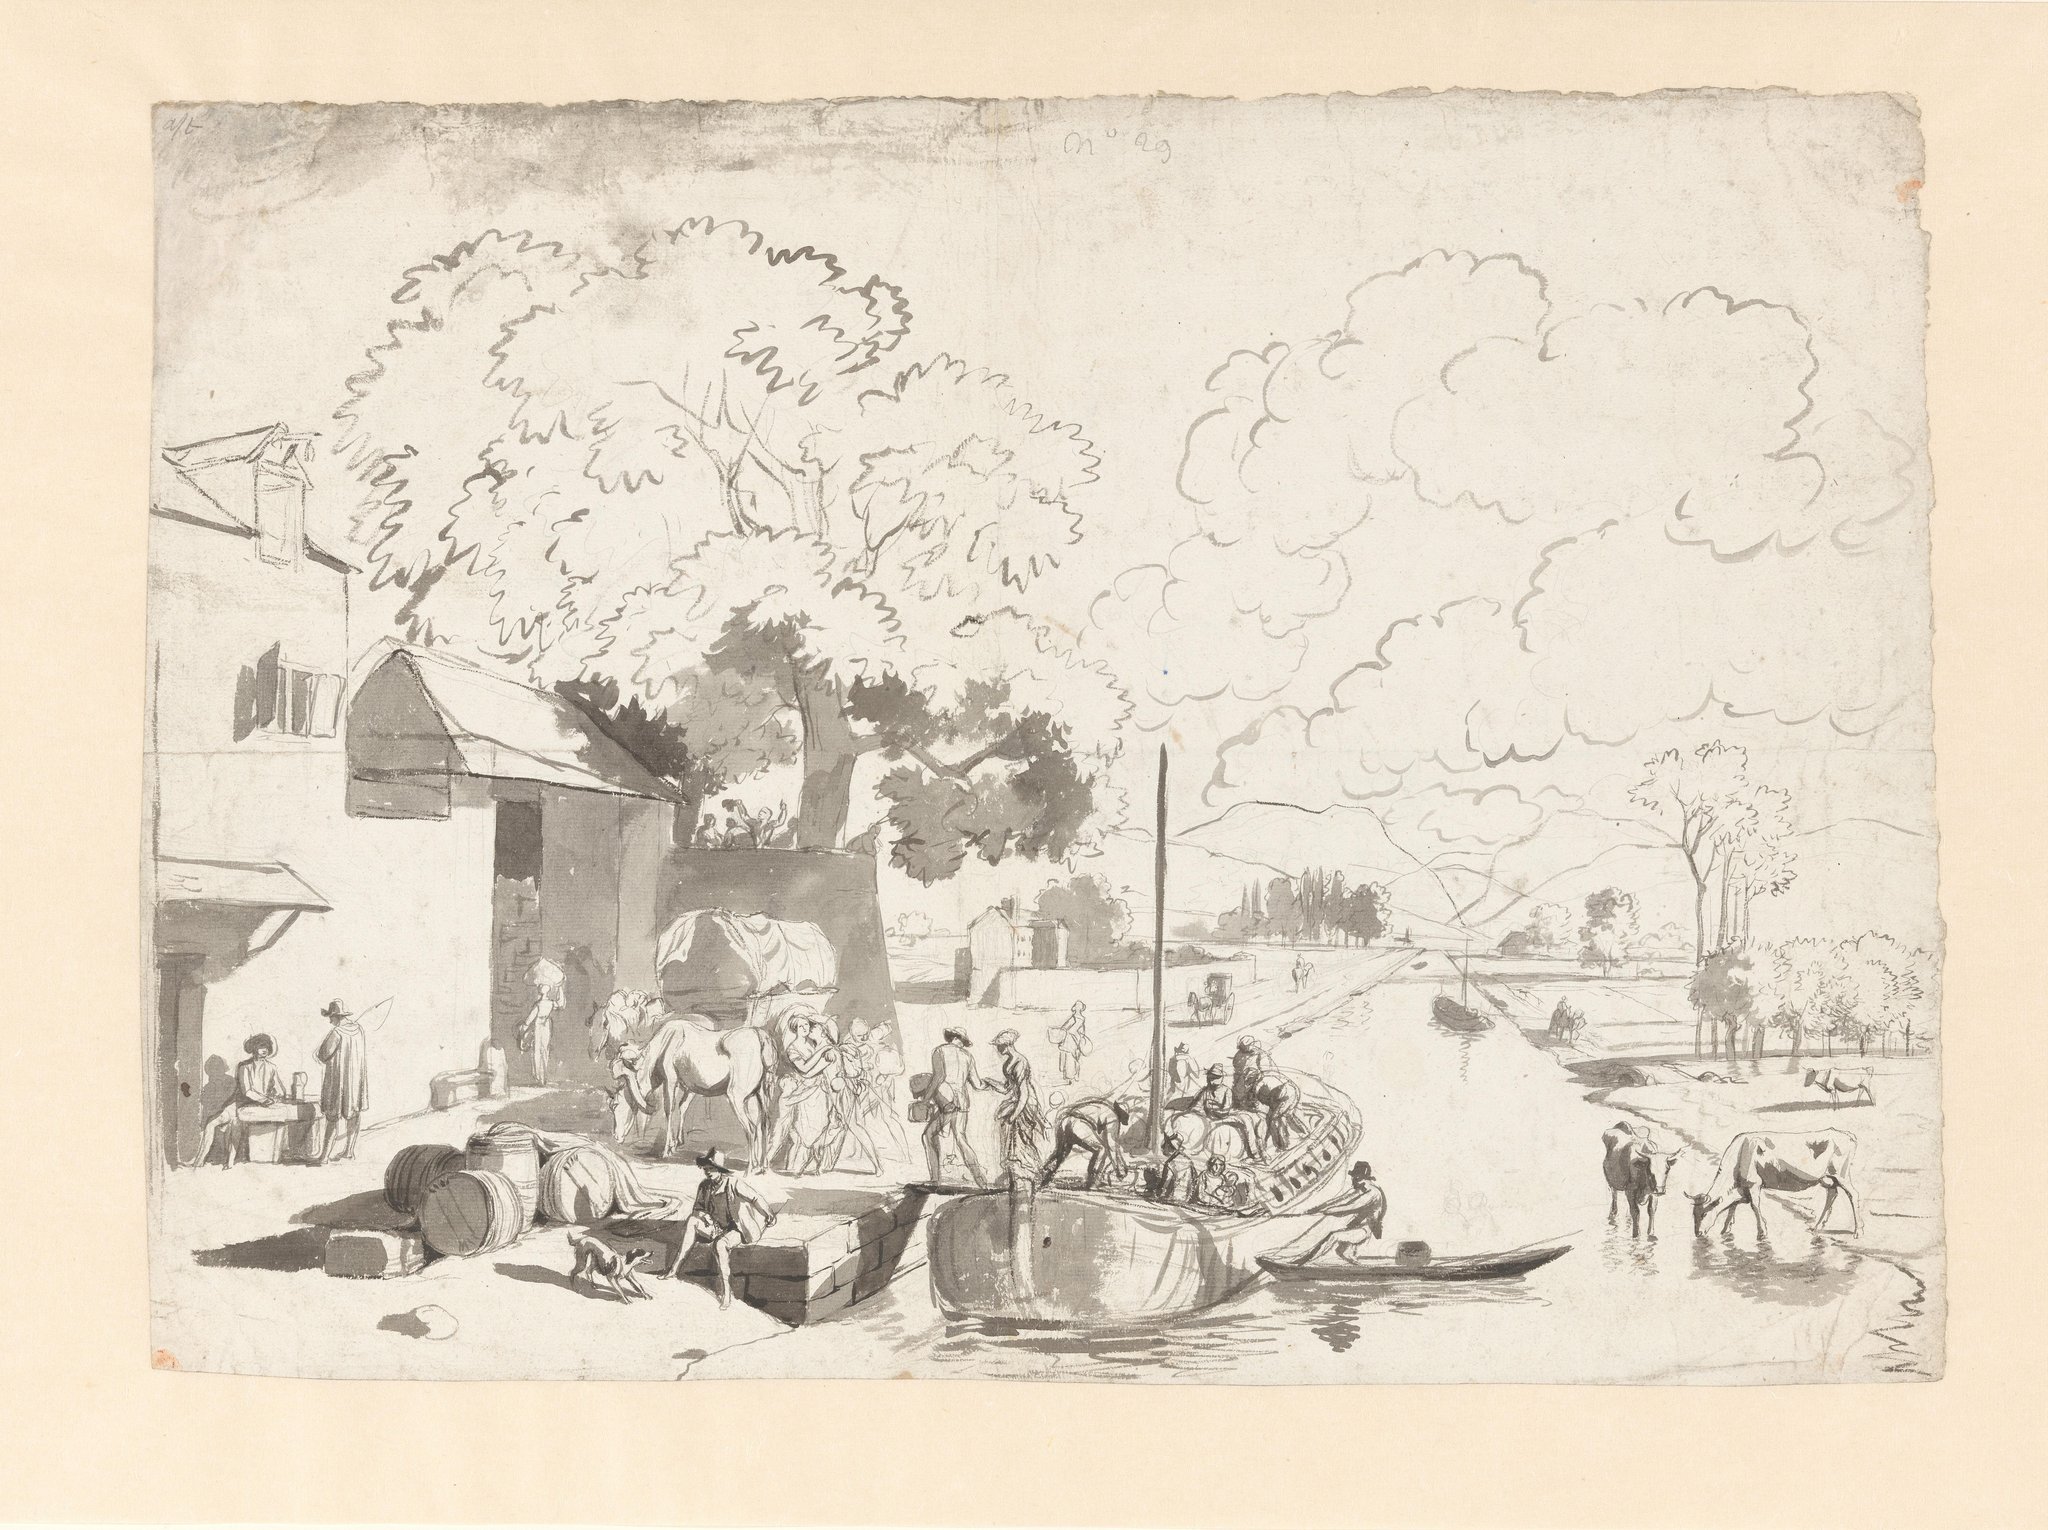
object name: drawing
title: Aankomst van een trekschuit bij een herberg aan een vaart in een bergachtig landschap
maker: Anonymous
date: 1800-1900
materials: paper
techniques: brush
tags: tow-boat, towing-barge (+ propulsion of vehicle, ship, etc. by animals), arrival and return ~ travelling, hotel, hostelry, inn